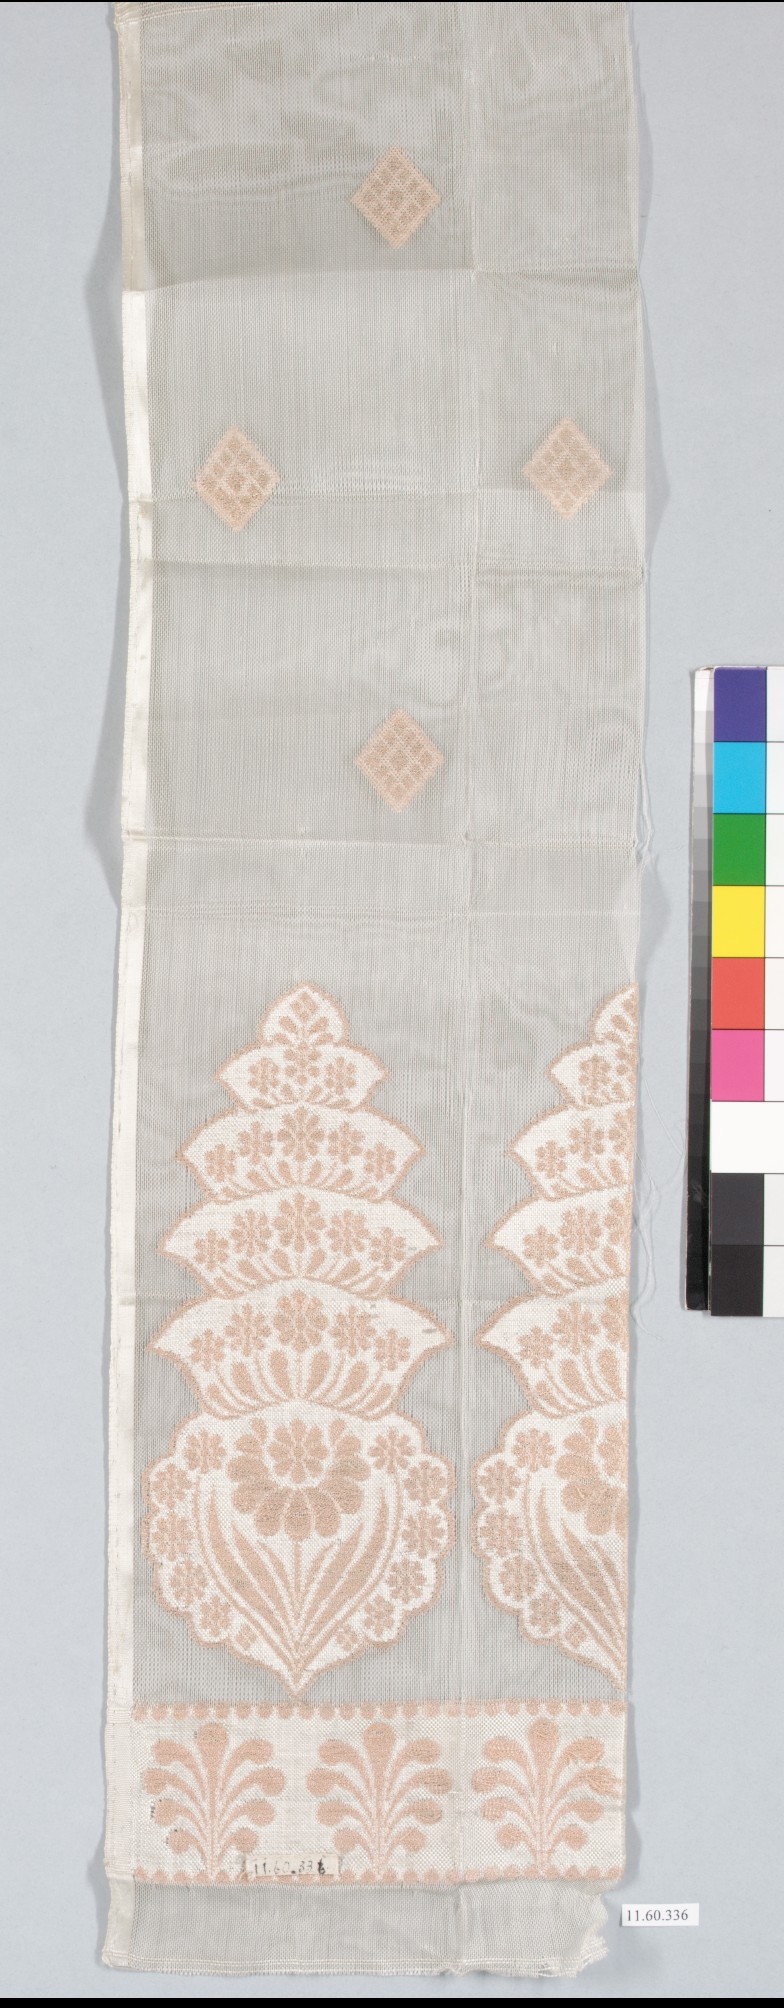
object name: fragment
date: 1801-1900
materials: silk